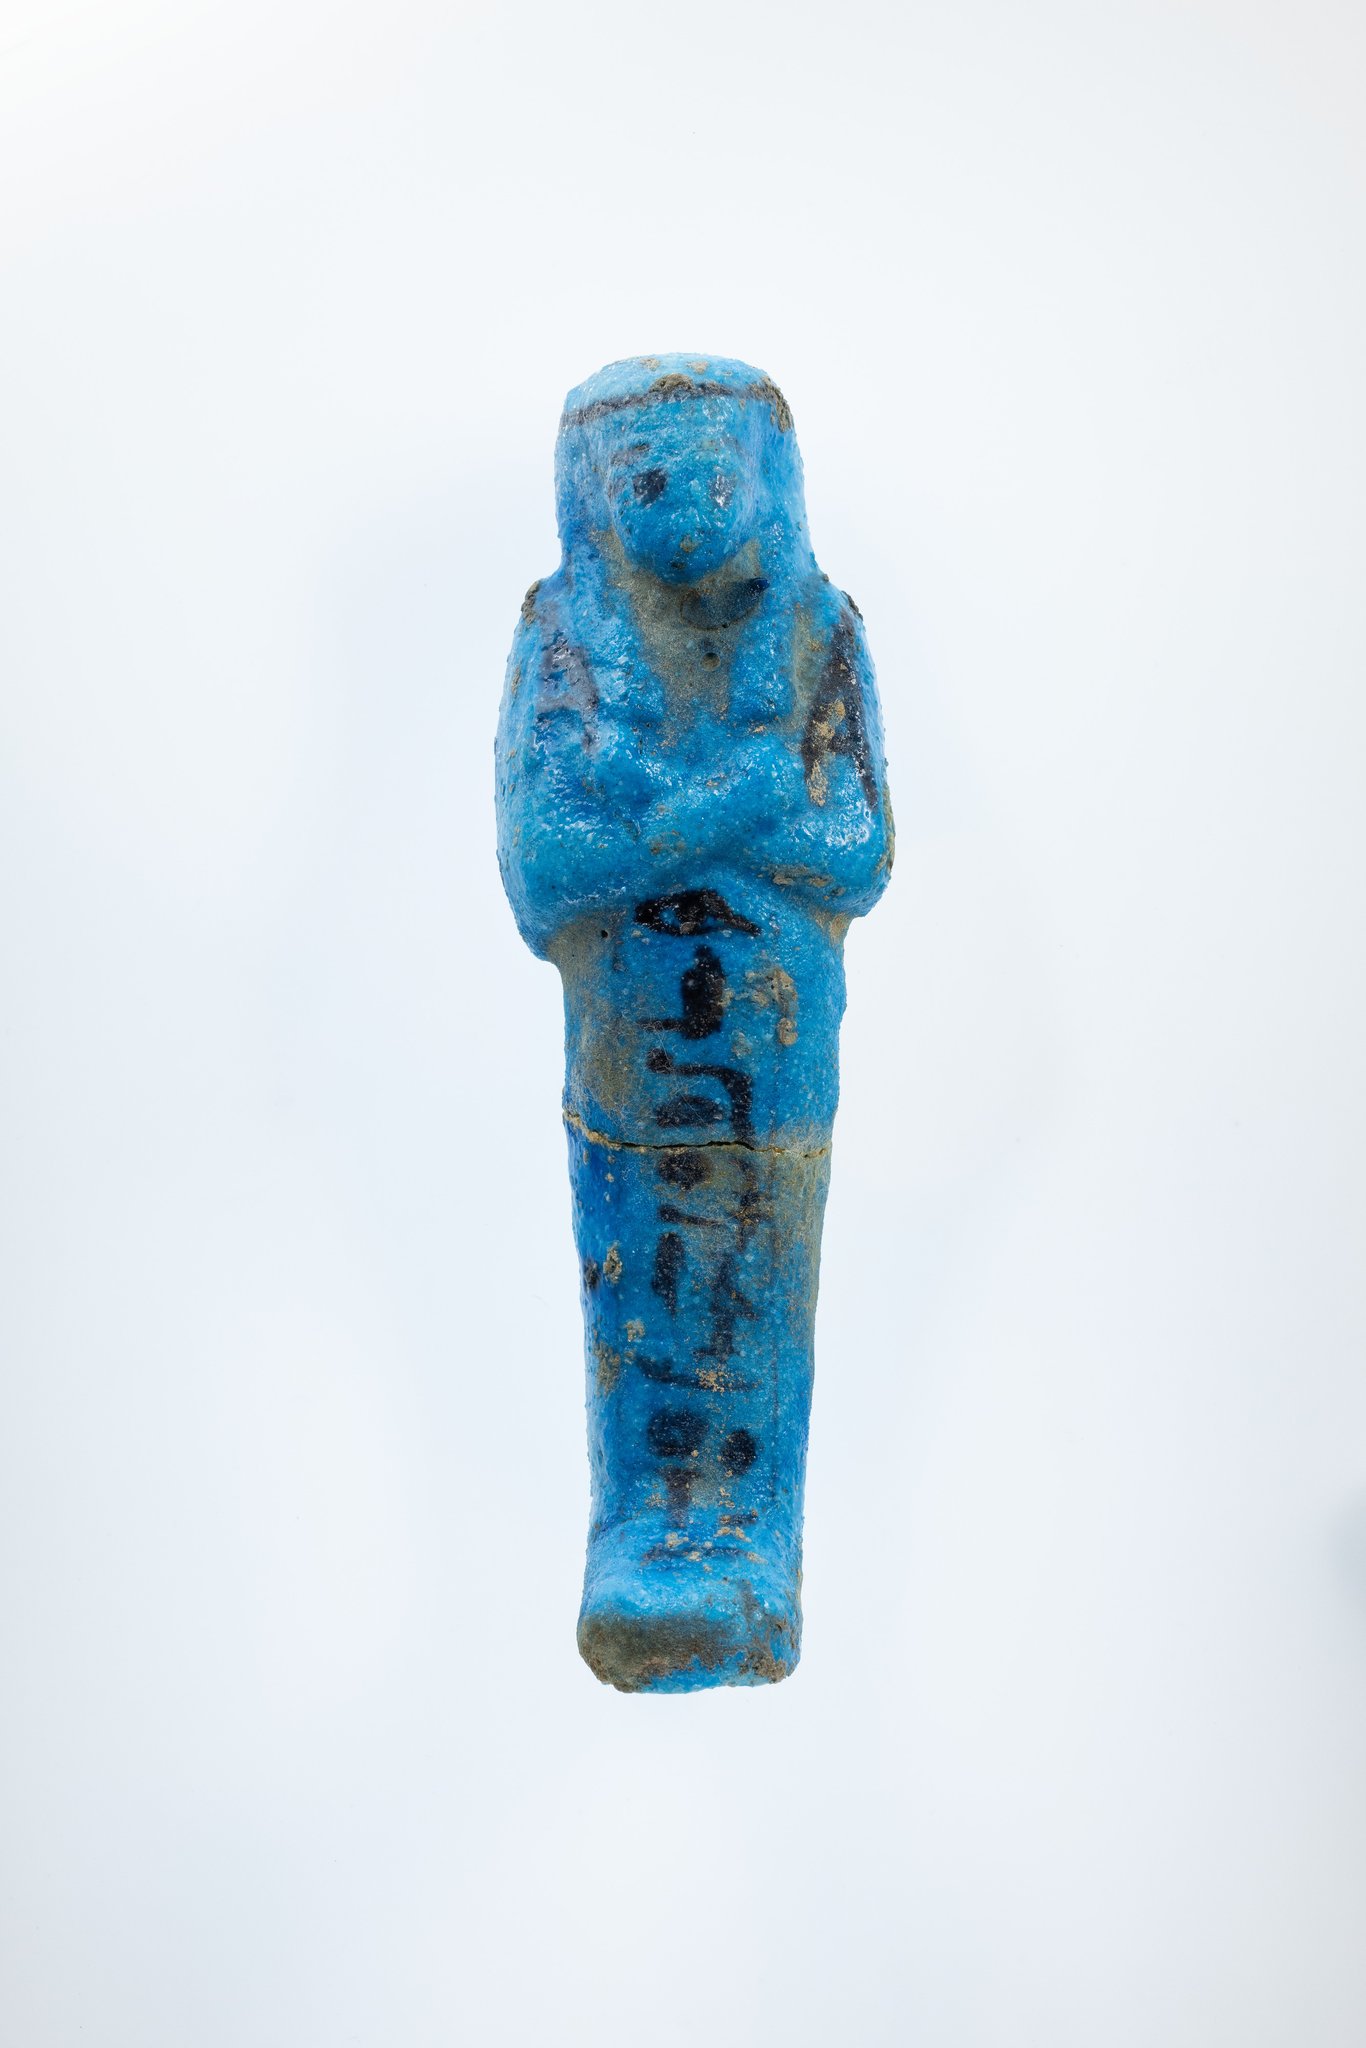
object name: shabti, djedkhonsuefankh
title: Shabti of Djedkhonsuefankh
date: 1070-945 BCE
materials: faience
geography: egypt